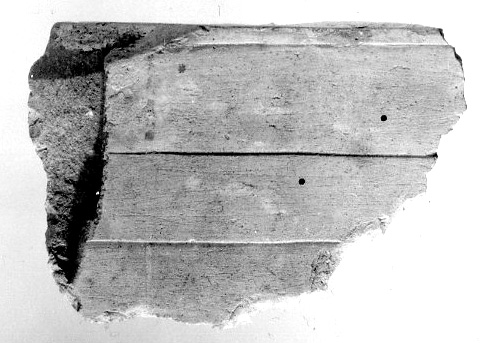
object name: relief fragment, tomb of meketre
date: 1981-1975 BCE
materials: limestone, paint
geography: egypt